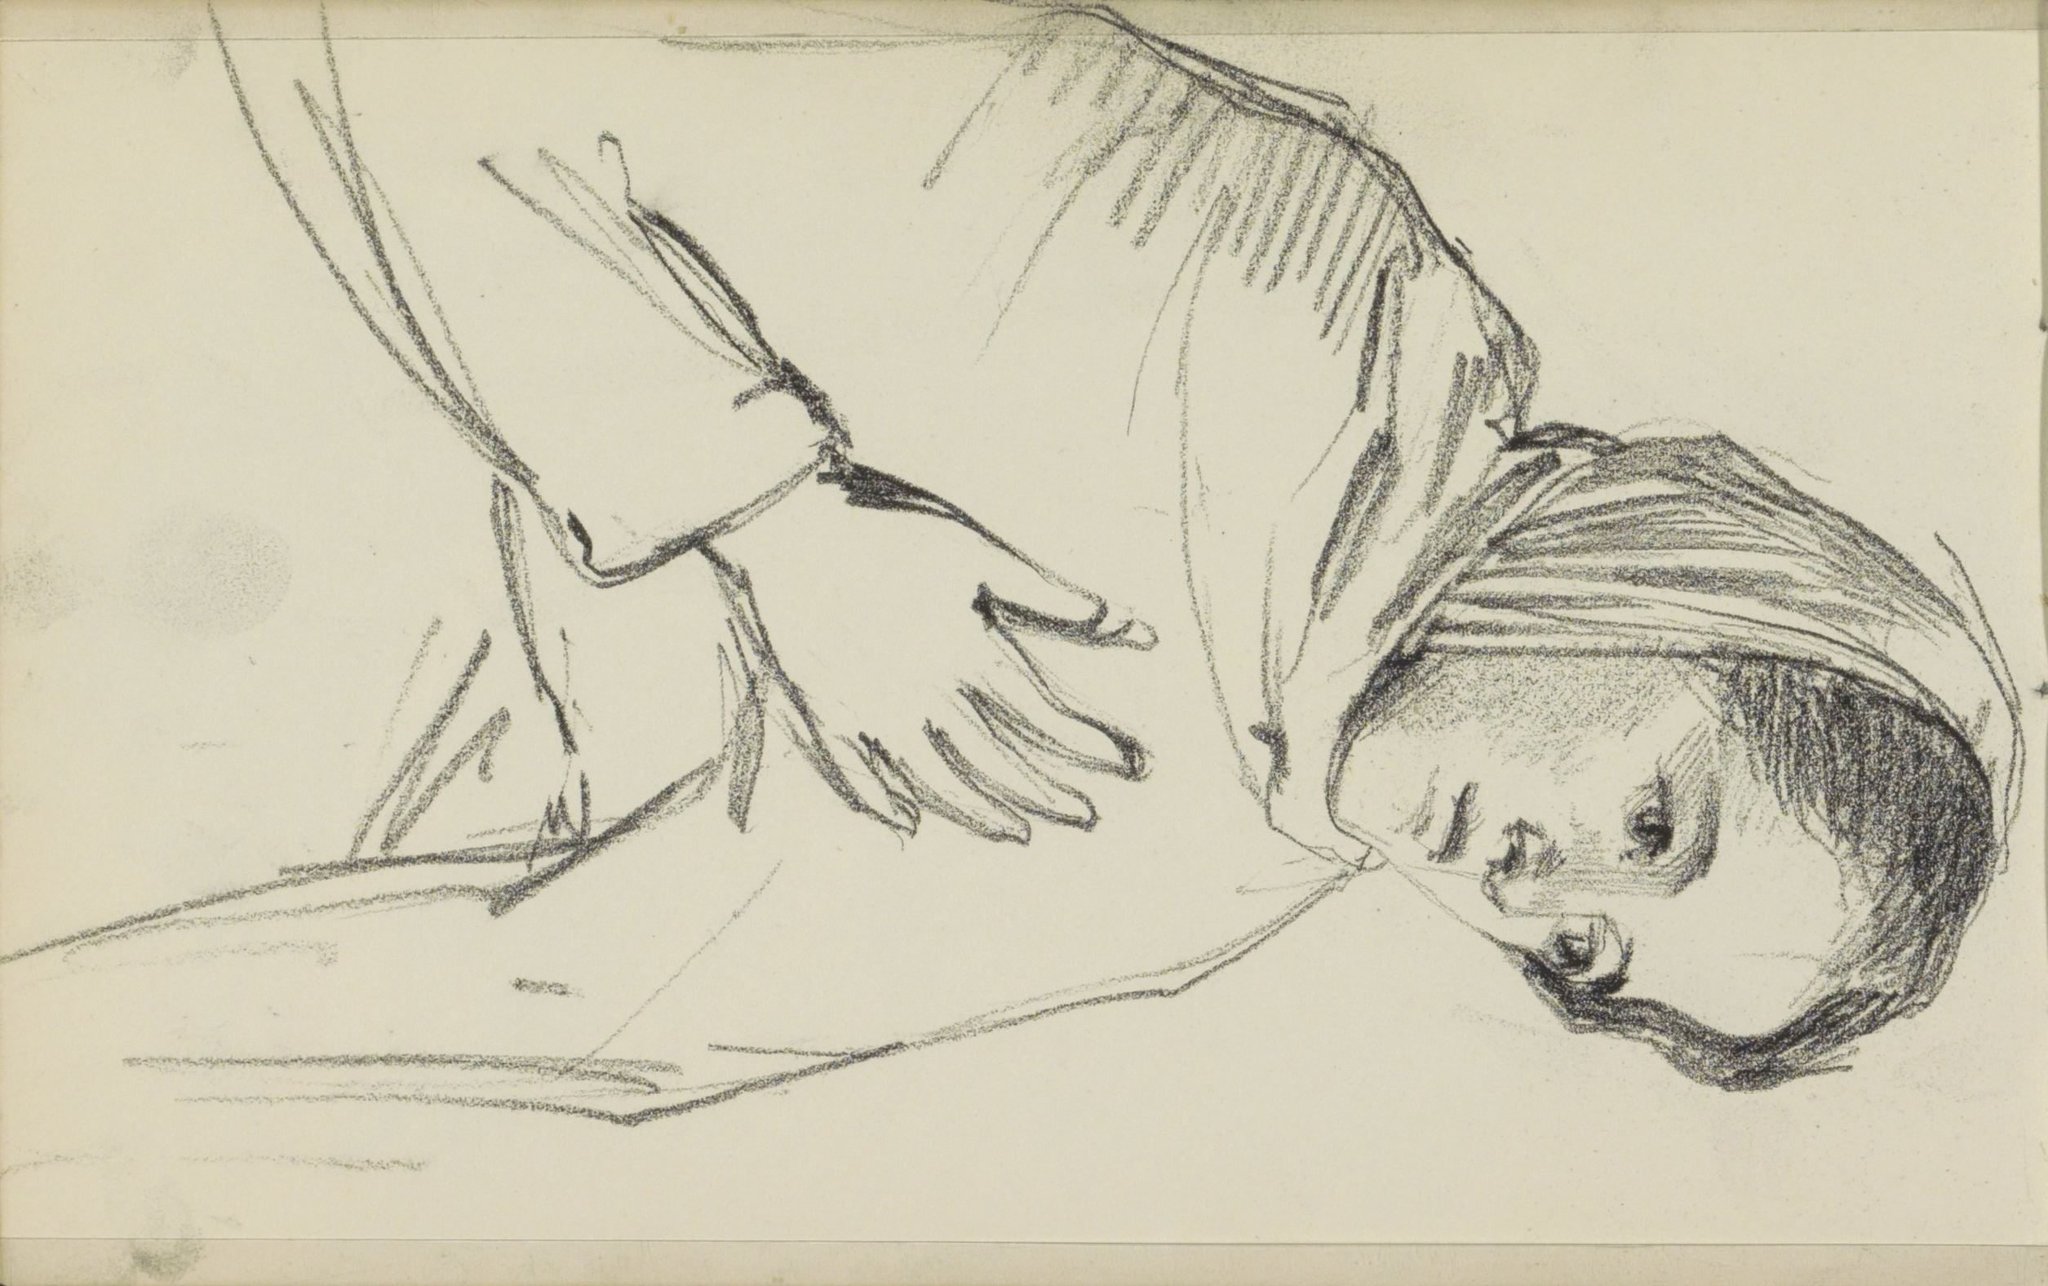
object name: sketchbook leaf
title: Vrouw met een shawl om haar hoofd en schouders, van voren gezien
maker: a.a.l. de grammont-hubrecht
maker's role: draughtsman, painter, print maker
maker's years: 1855-1913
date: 1892-1913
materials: chalk, paper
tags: adult woman, head-gear (with name)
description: Blad 9 verso uit een schetsboek met 31 bladen.